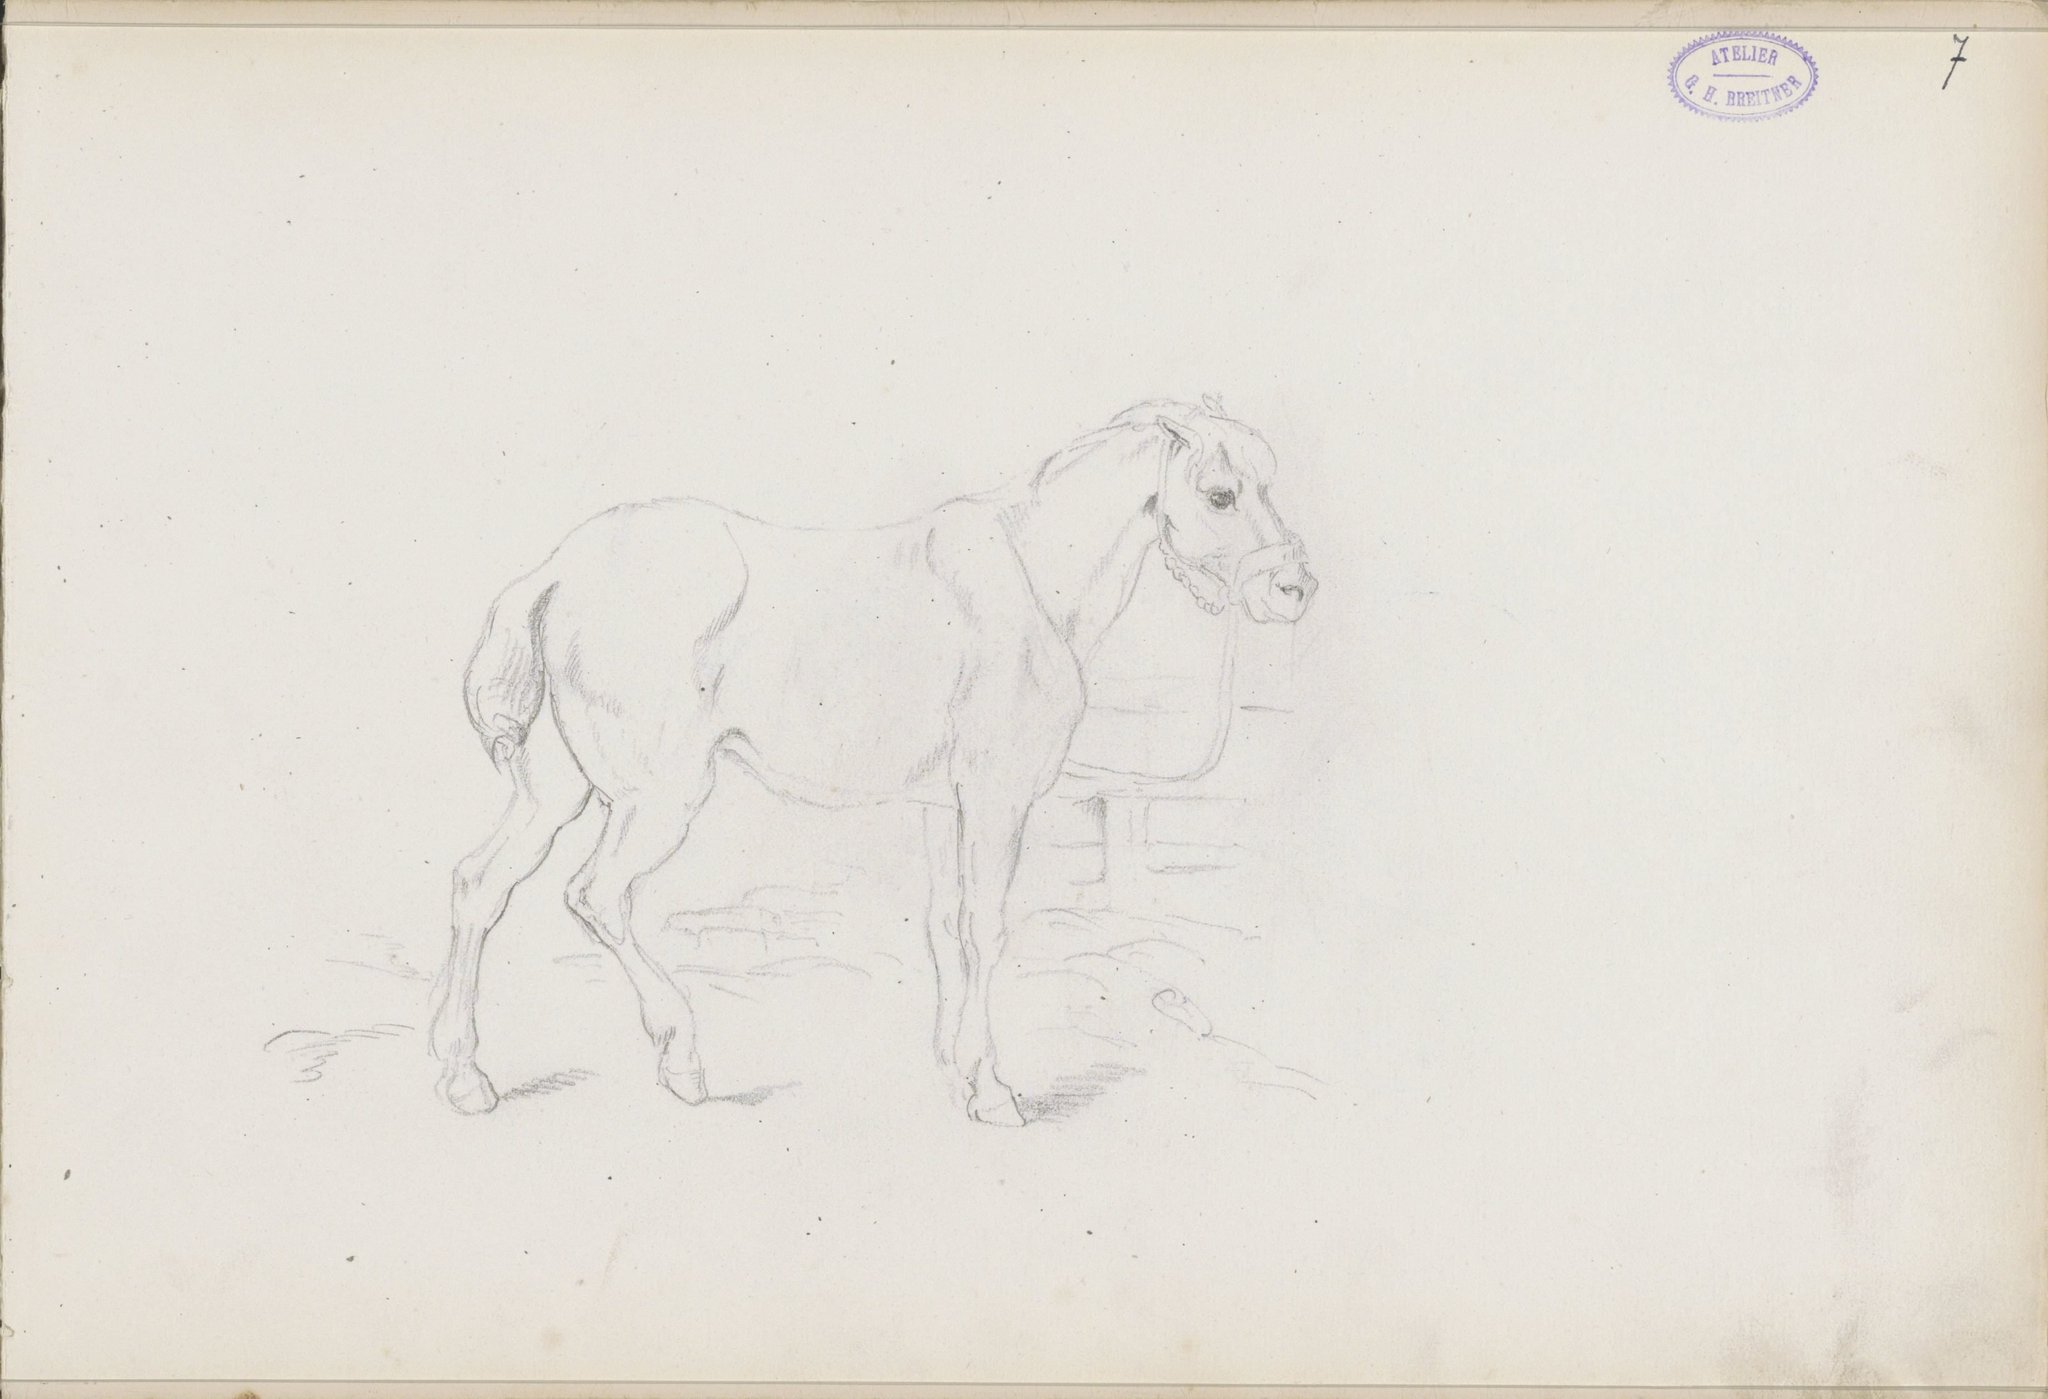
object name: sketchbook leaf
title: Staand paard met hoofdstel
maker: george hendrik breitner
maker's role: draughtsman, painter, print maker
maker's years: 1857-1923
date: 1809-1872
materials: paper, pencil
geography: rotterdam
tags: horse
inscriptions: workshop stamp: Lugt 291d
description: Blad 7 recto uit een schetsboek met 32 bladen.